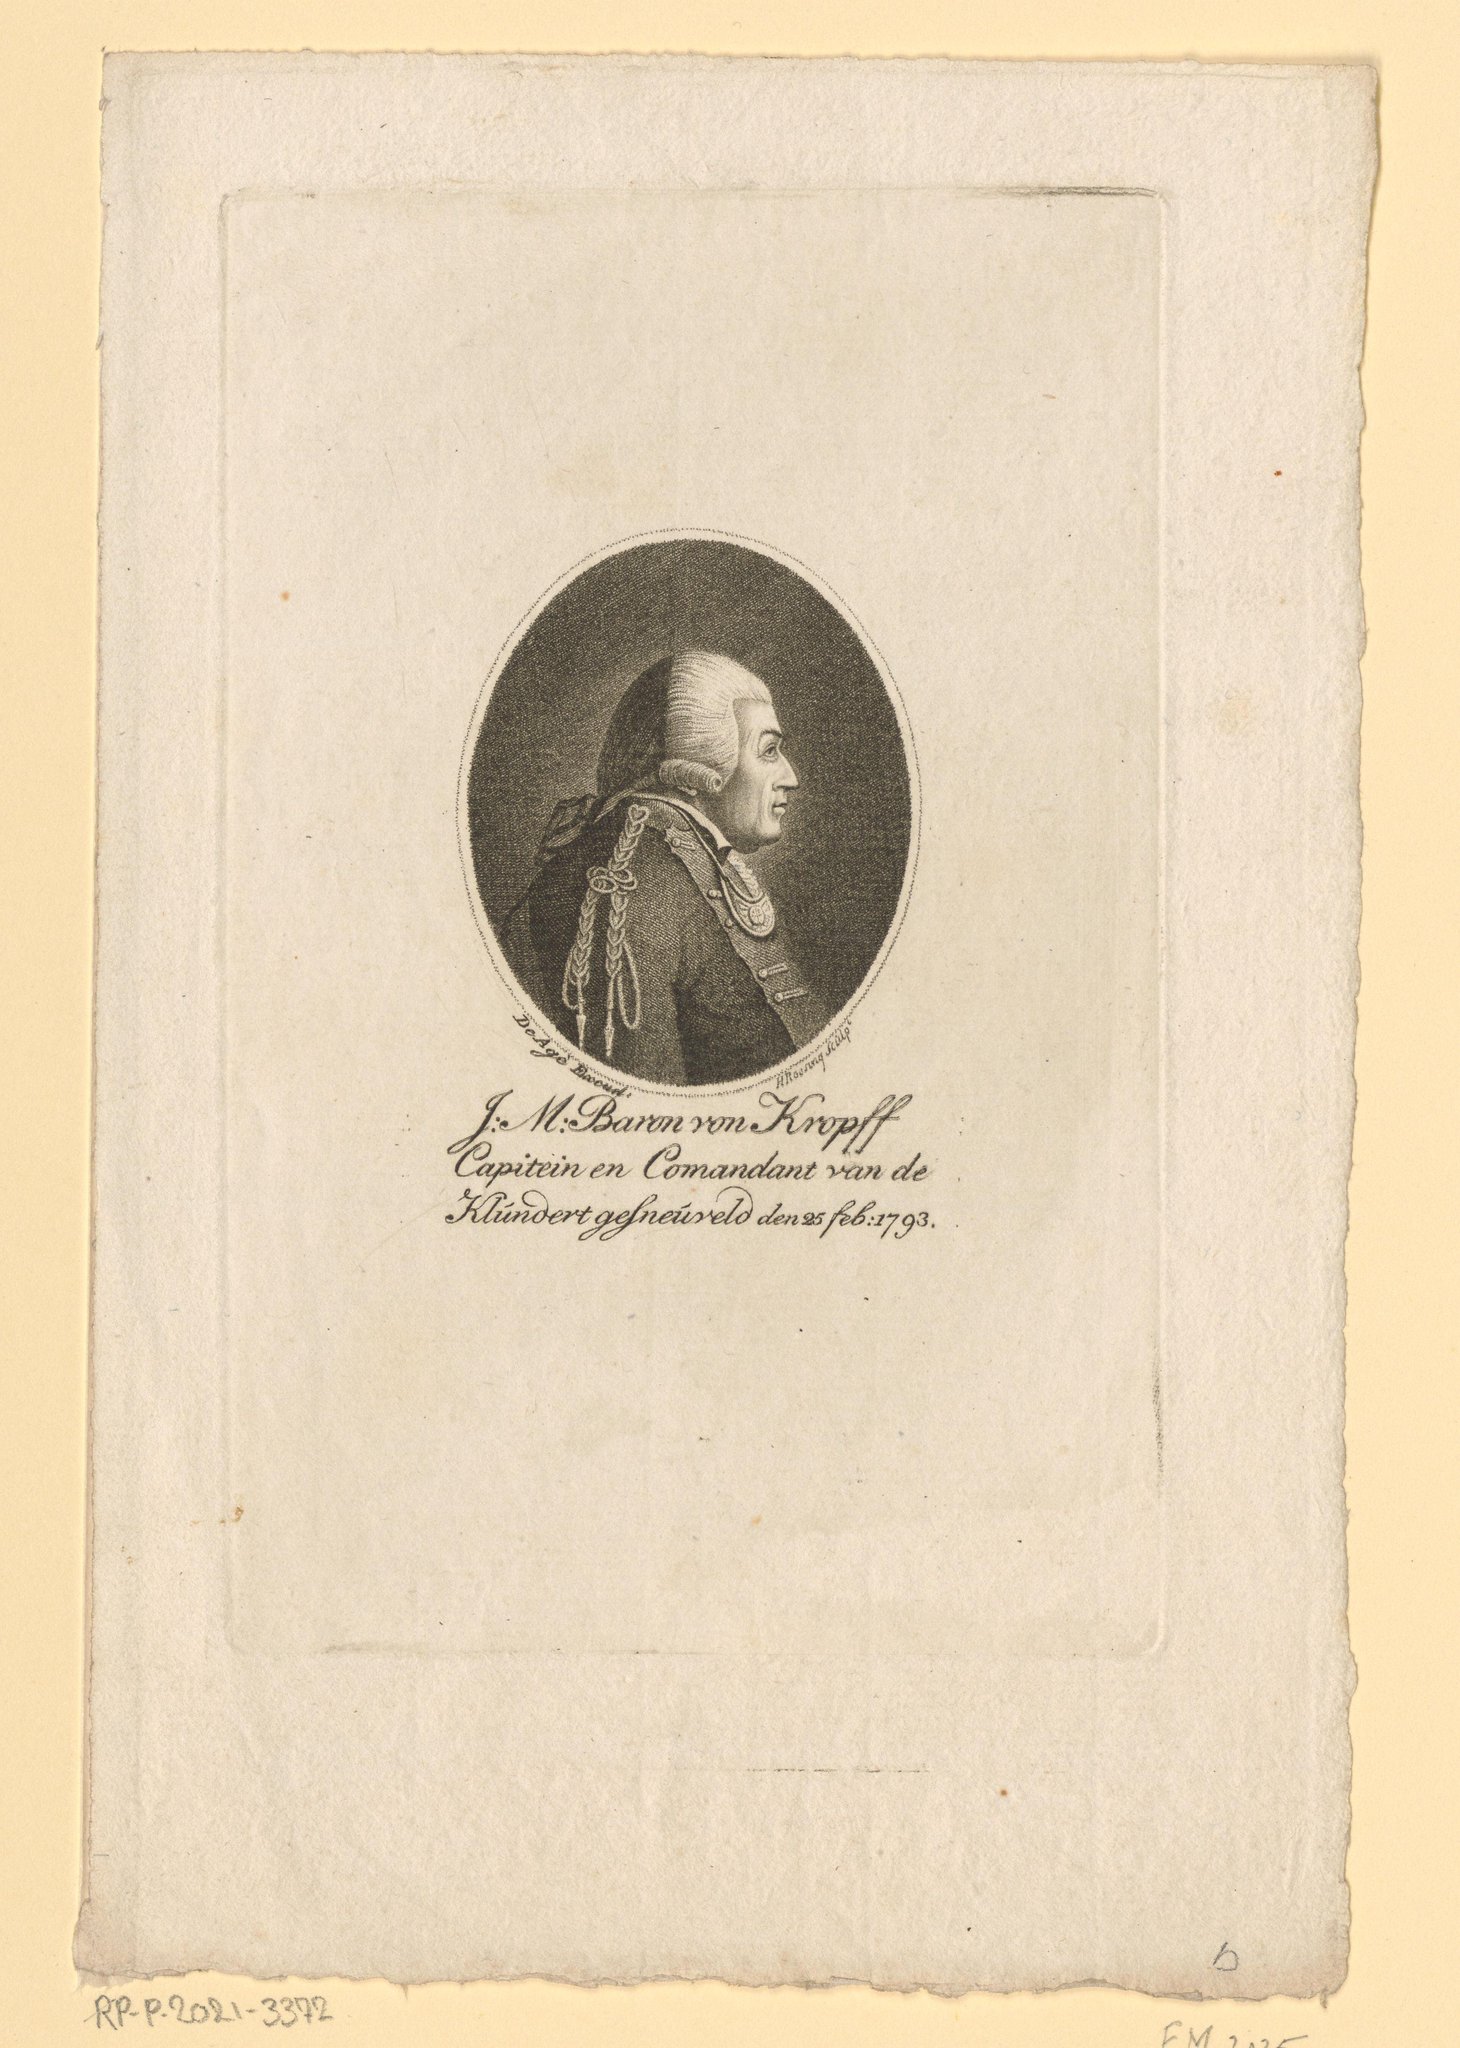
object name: print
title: Portret van Joachim Maurits baron van Kropff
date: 1793-1801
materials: paper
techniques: engraving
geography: the hague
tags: klundert, historical persons